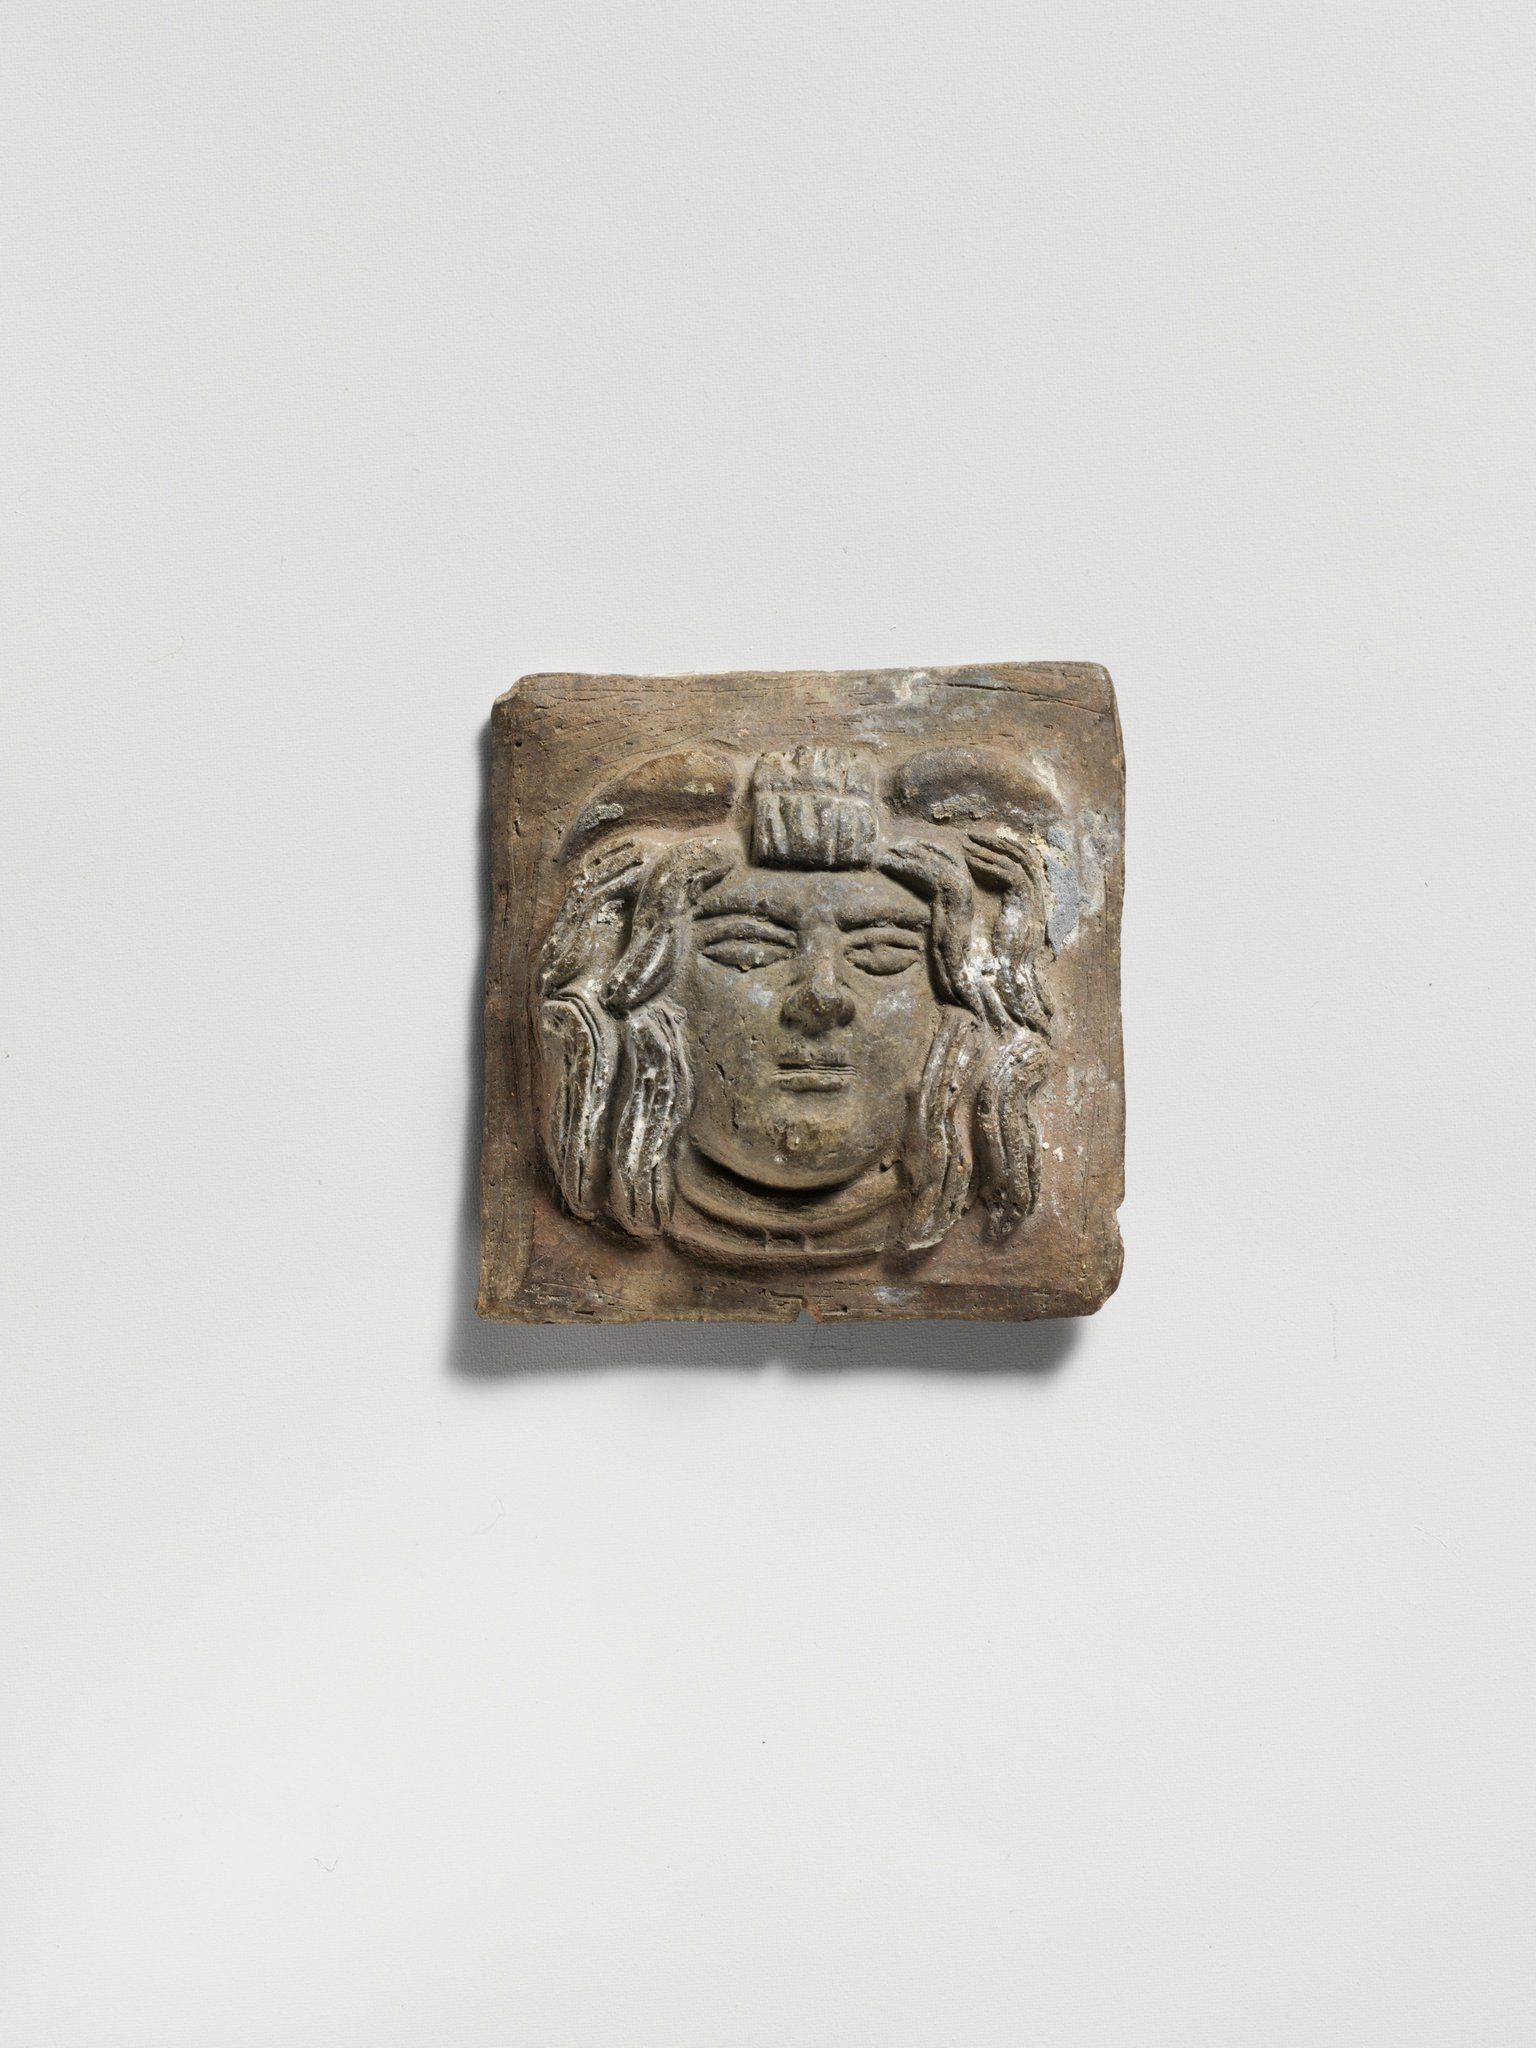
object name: head of medusa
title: Terracotta relief plaque with head of Medusa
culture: greek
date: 200-101 BCE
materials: terracotta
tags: heads,medusa